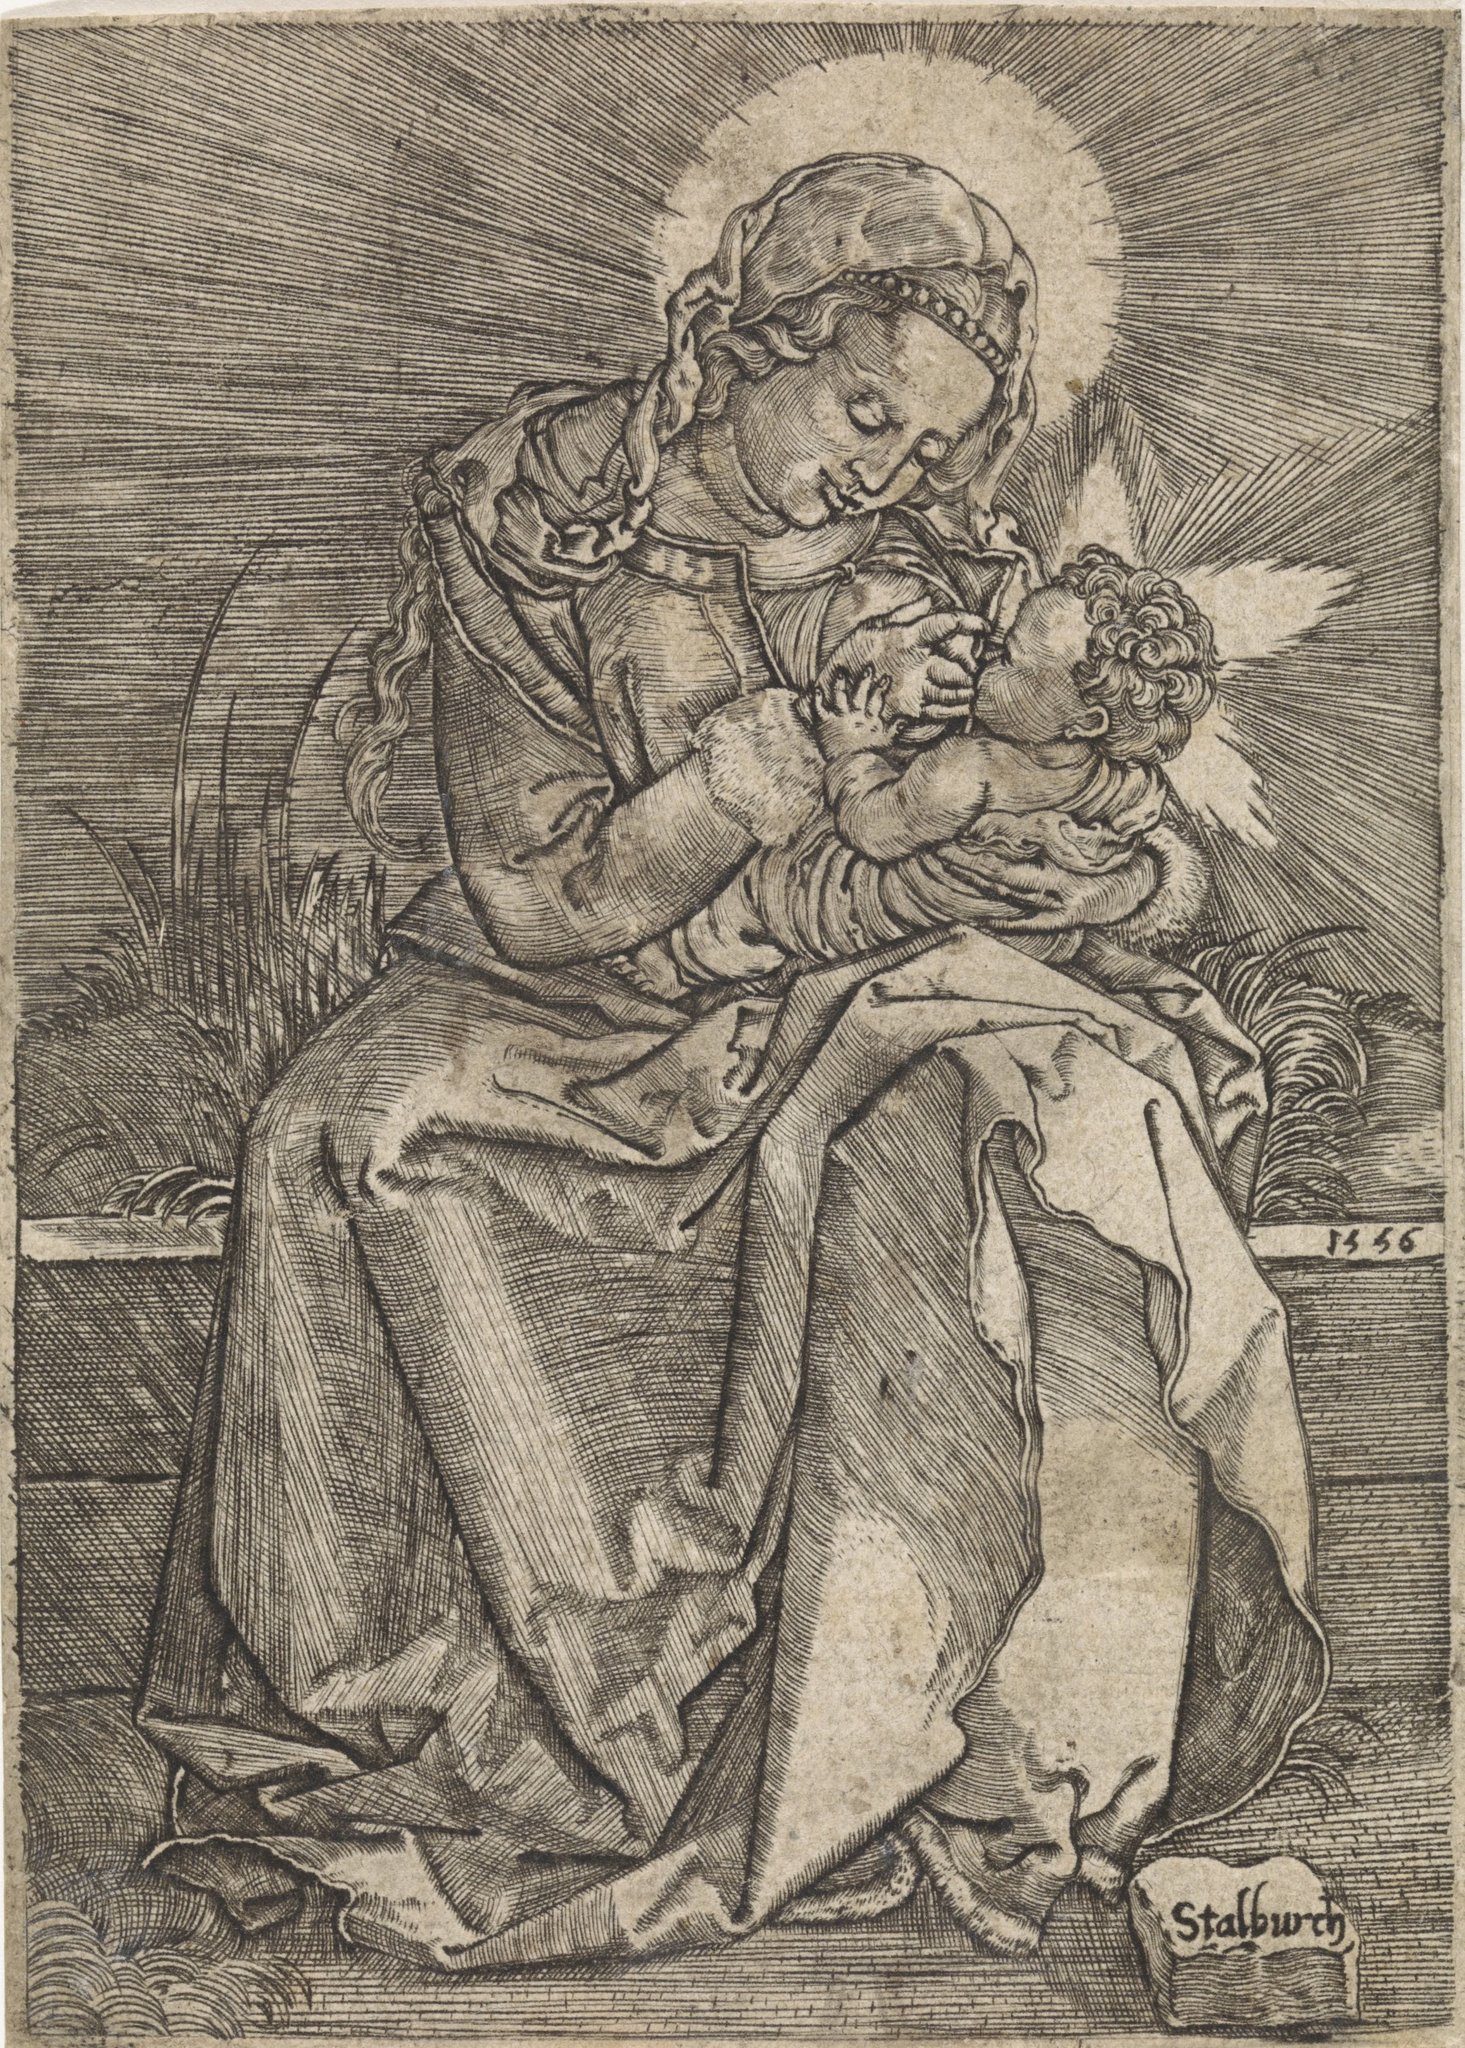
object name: print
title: Maria met Christuskind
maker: jan van stalburch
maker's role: print maker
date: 1556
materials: paper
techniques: engraving, etching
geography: leuven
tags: christ-child suckling, or beginning to suckle, e.g. mary uncovering her breast ~ madonna-representations, mary sitting or enthroned, the christ-child in front of her in her lap (or in front of her bosom)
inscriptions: collector's mark: Lugt 240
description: Maria geeft het Christuskind de borst. Zij zit op een muurtje.